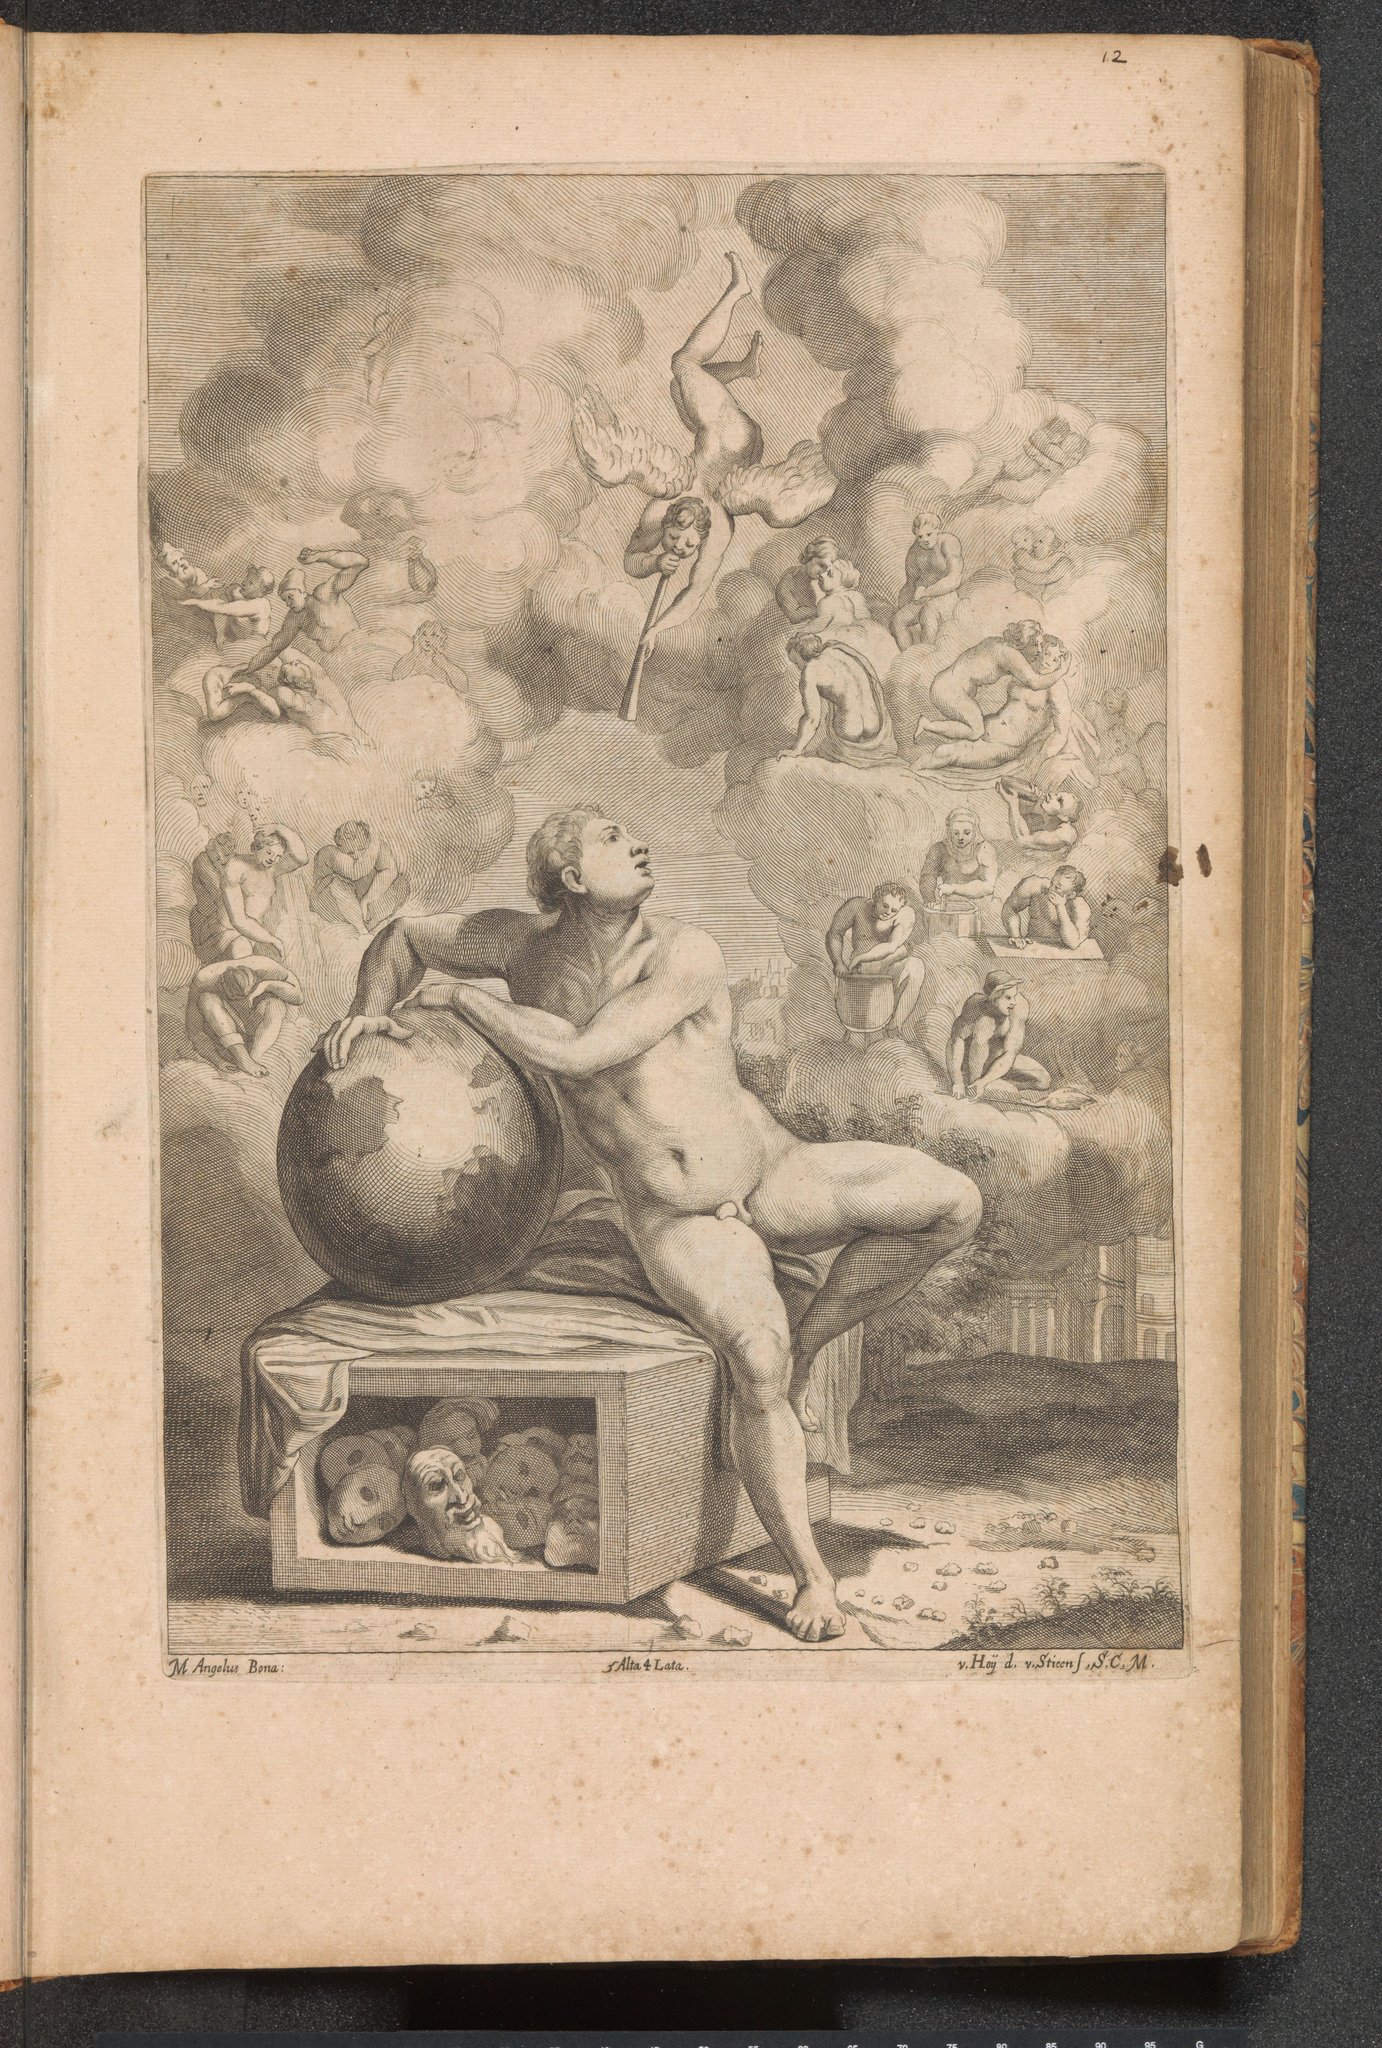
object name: album leaf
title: Naakte man met wereldbol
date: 1660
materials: paper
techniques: engraving, etching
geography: brussels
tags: mask, the (nude) human figure; 'corpo humano' (ripa) (+ sitting), globe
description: De tekening van Michelangelo bevindt zich in The Courtauld Gallery te Londen. David Teniers heeft waarschijnlijk van alle schilderijen uit de collectie van Leopold Willem van Oostenrijk een olieverfstudie op doek of paneel vervaardigd (zgn. pasticcio), die als voorbeeld voor de prentmakers diende. Het is niet altijd duidelijk of de pasticci door hem zijn gemaakt of door zijn atelier. Niet alle pasticci zijn overgeleverd.